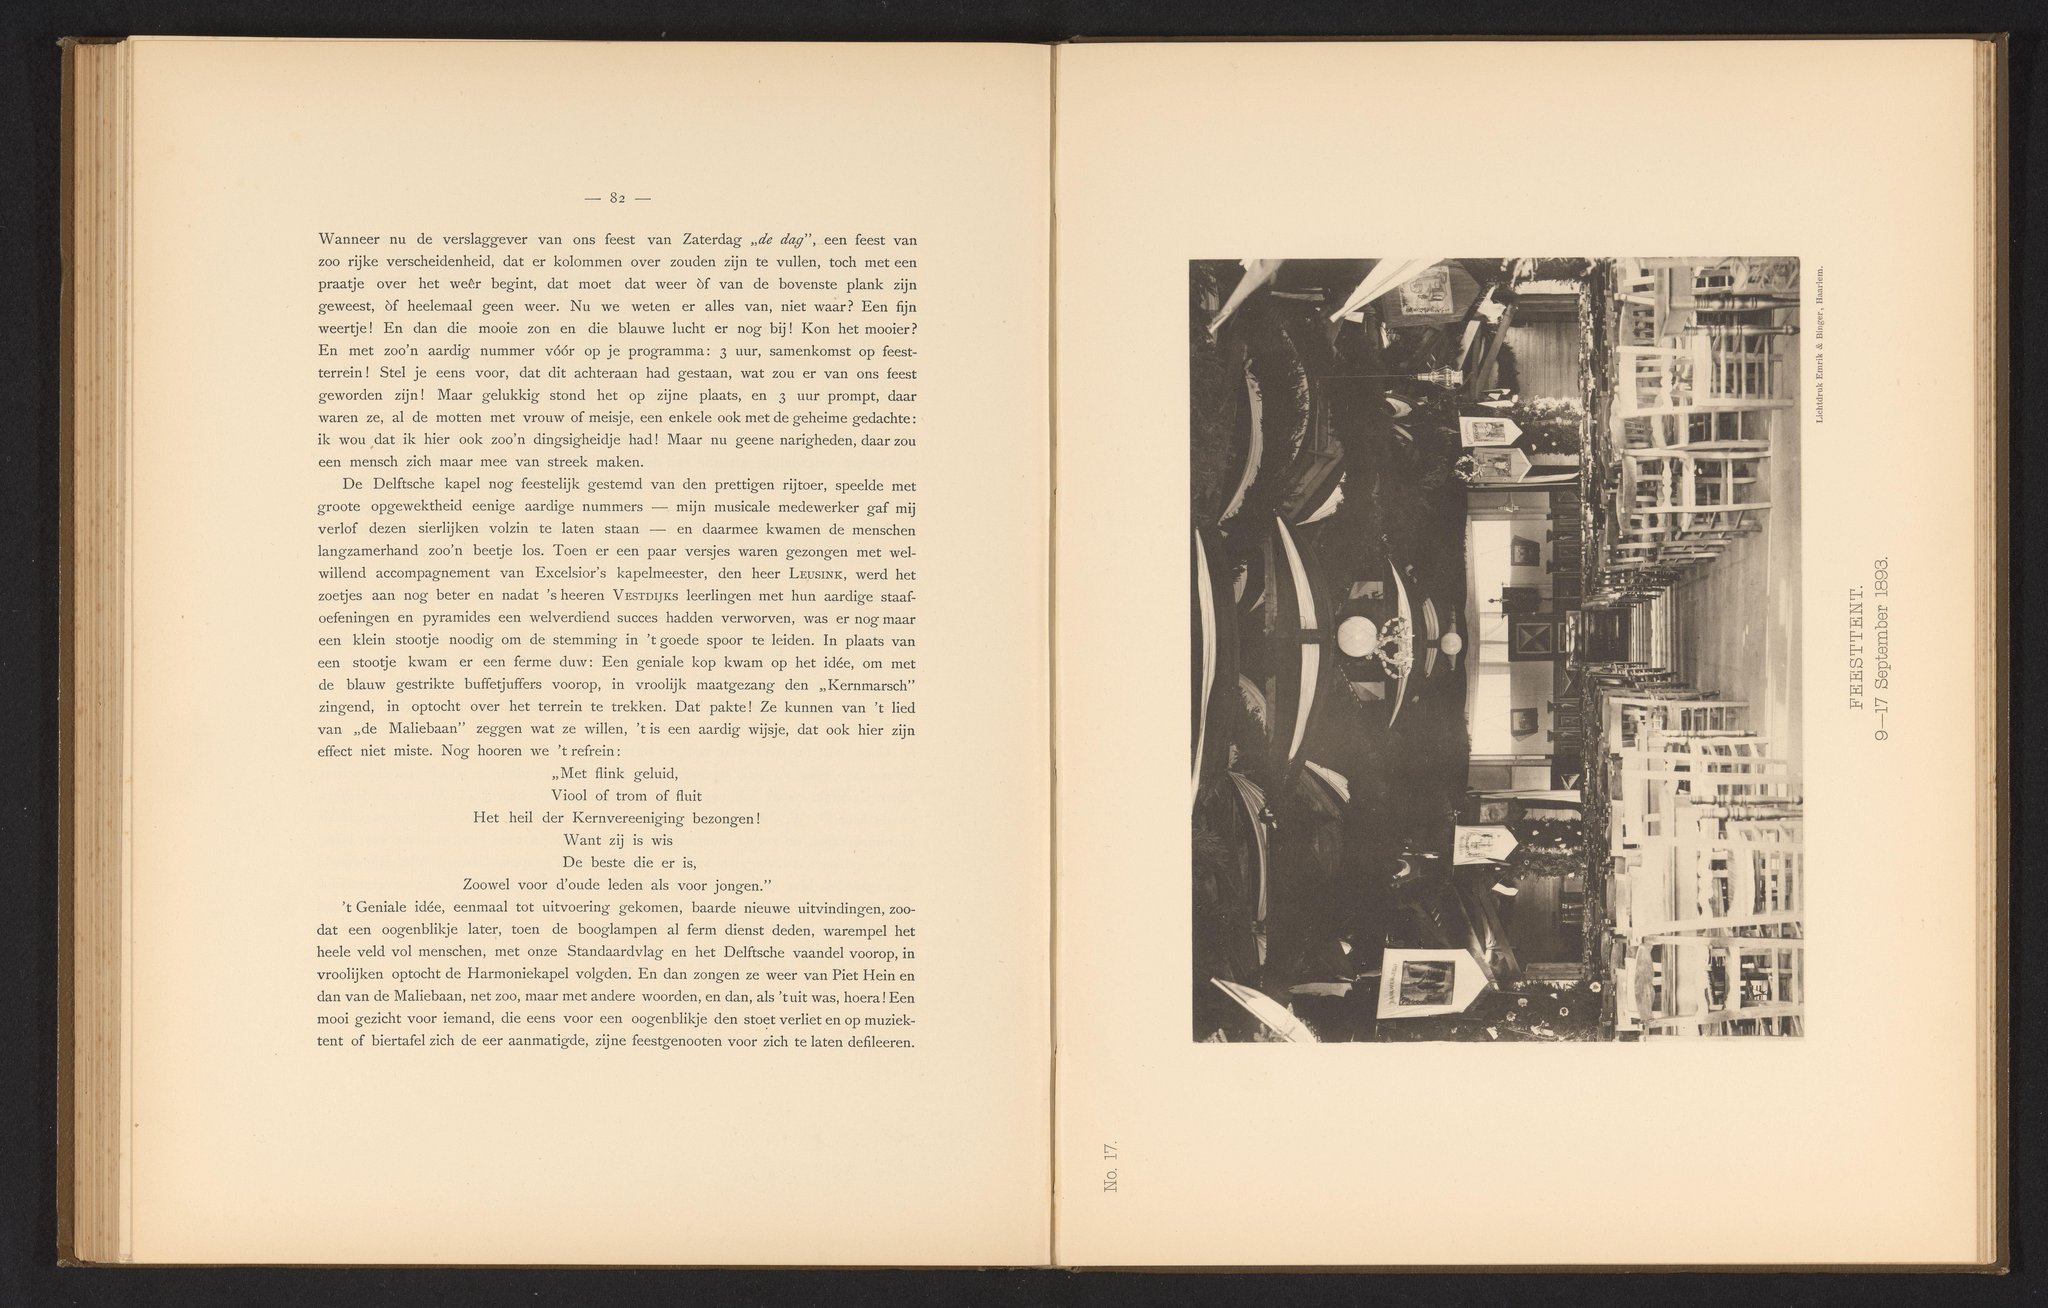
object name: page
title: Feesttent. 9-17 September 1893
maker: Anonymous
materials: paper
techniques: photograph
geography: hengelo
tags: festivities (+ festive decoration ~ festive activities), festivities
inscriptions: number: ‘No. 17.’